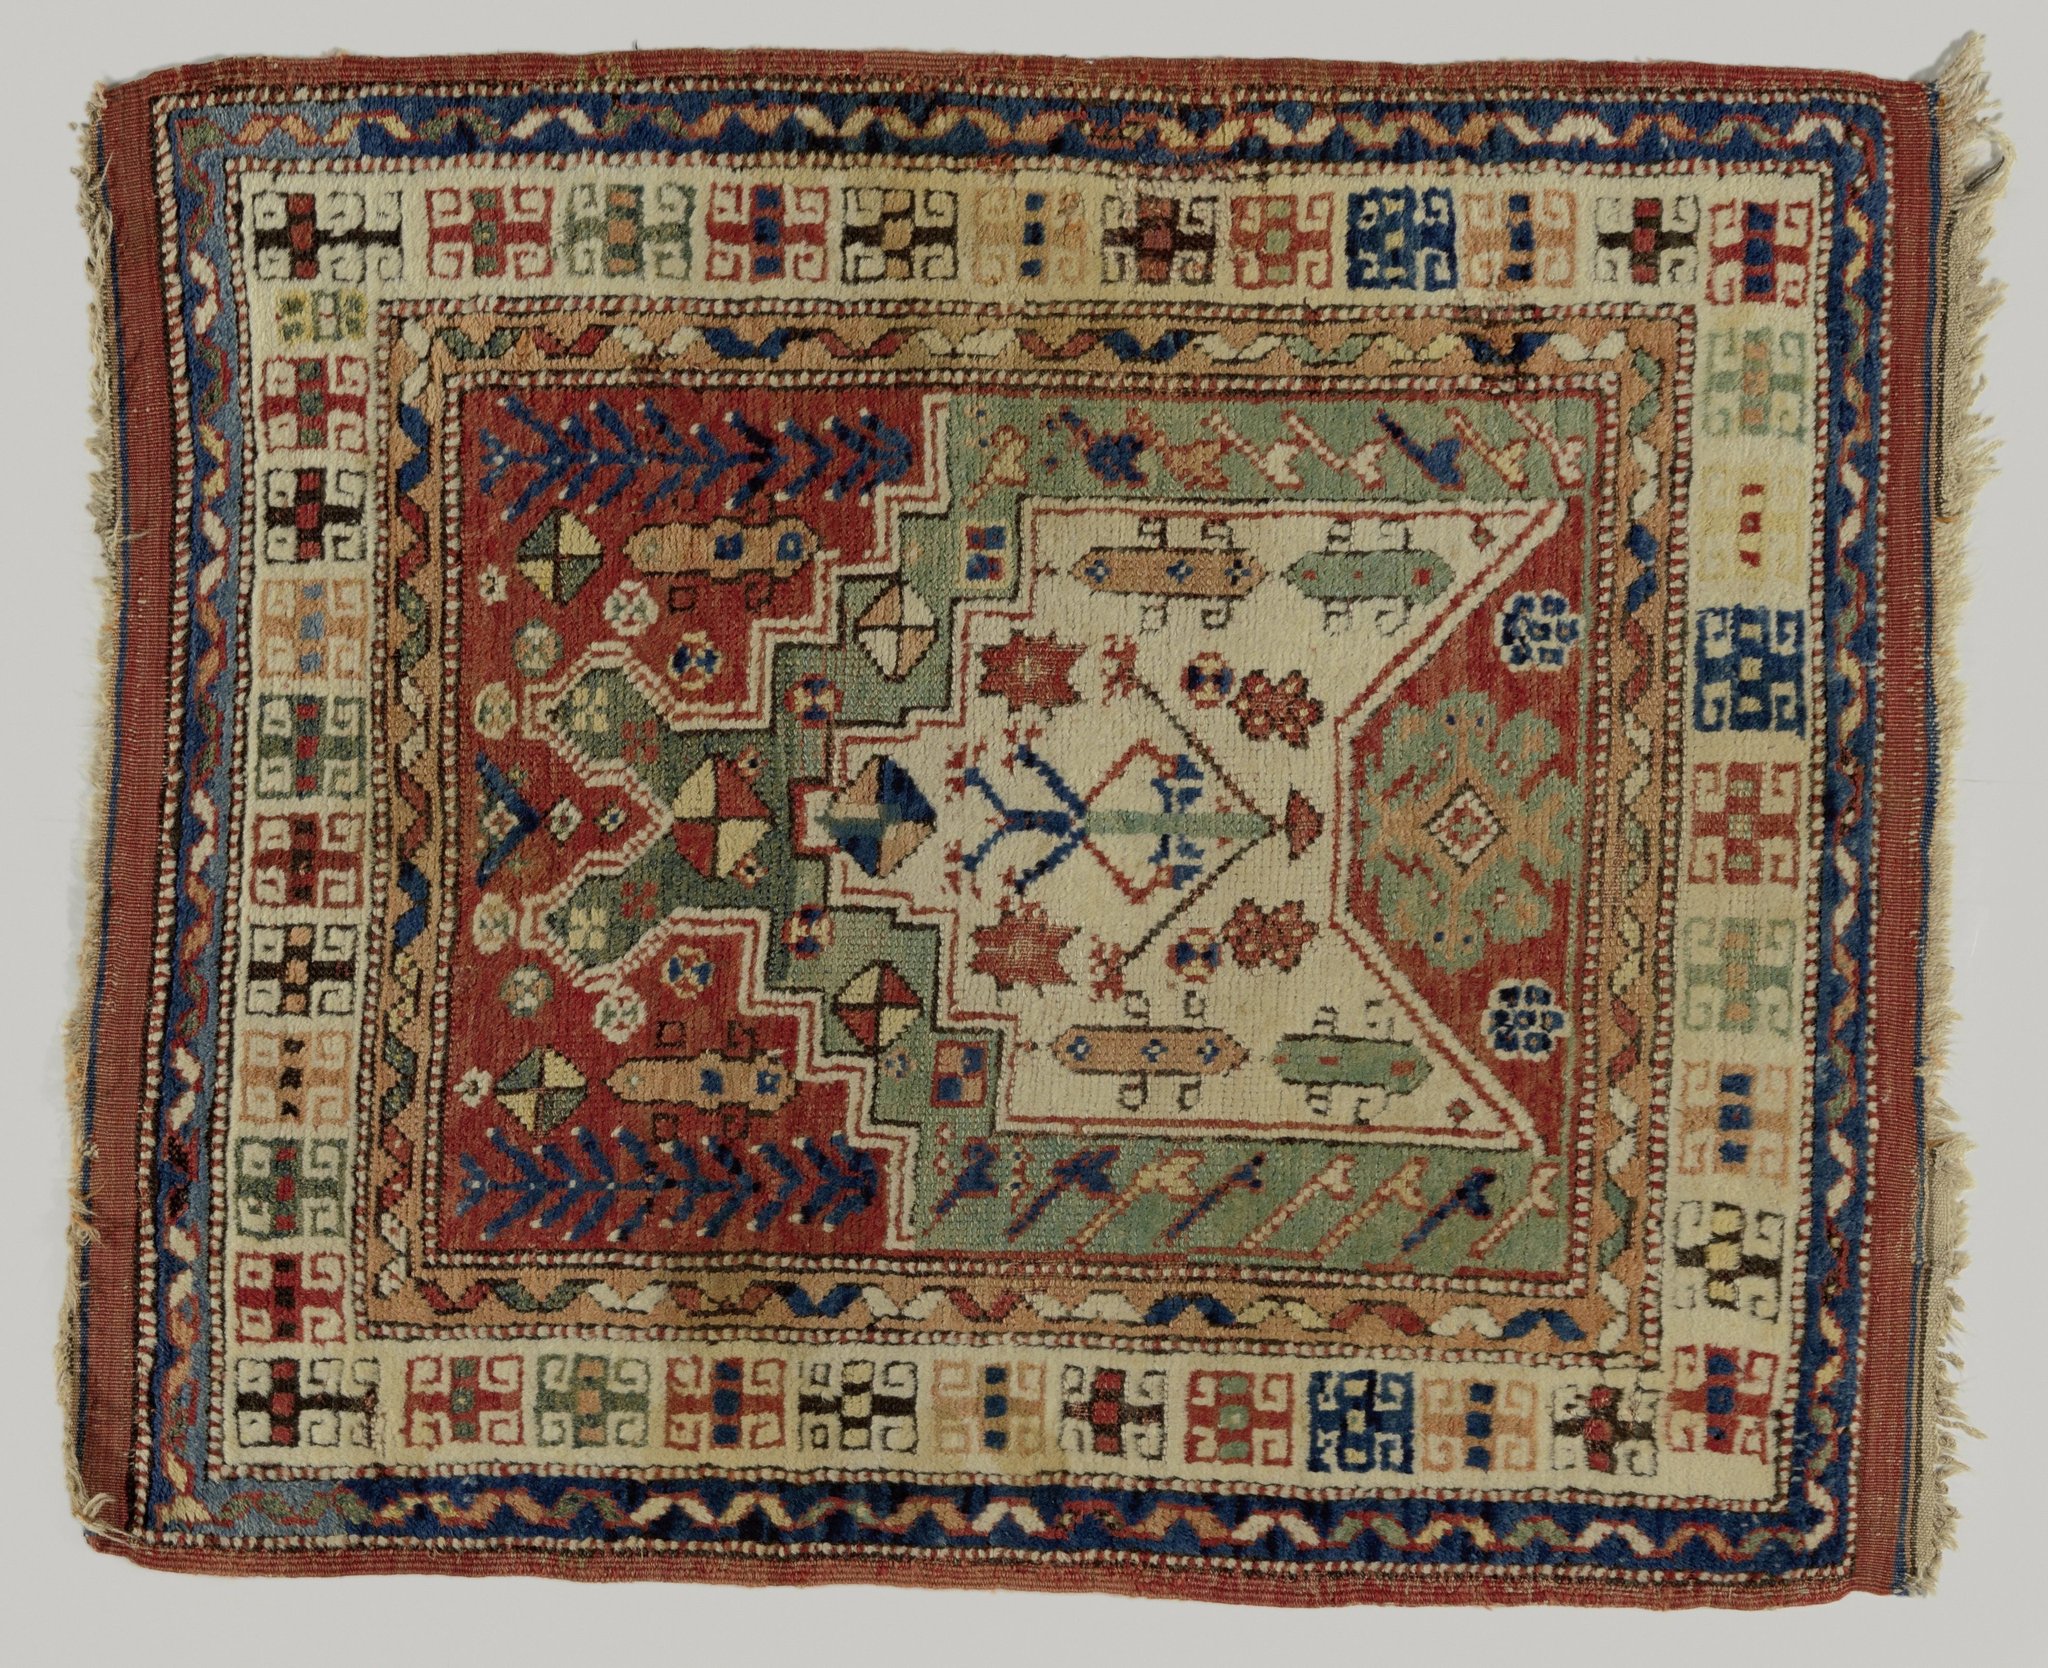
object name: oriental rug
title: Oosters tapijt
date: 1840-1900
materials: wool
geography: bergama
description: Oosters tapijt, bidkleed met een sleutelgatmotief. Witte mihrab met onderaan een sleutelgatmotief. Vulling onder andere met een levensboom. Drievoudige randen, waarvan de breedtse wit met vierkante dubbelhaken. Knoop: Ghiordes knoop.